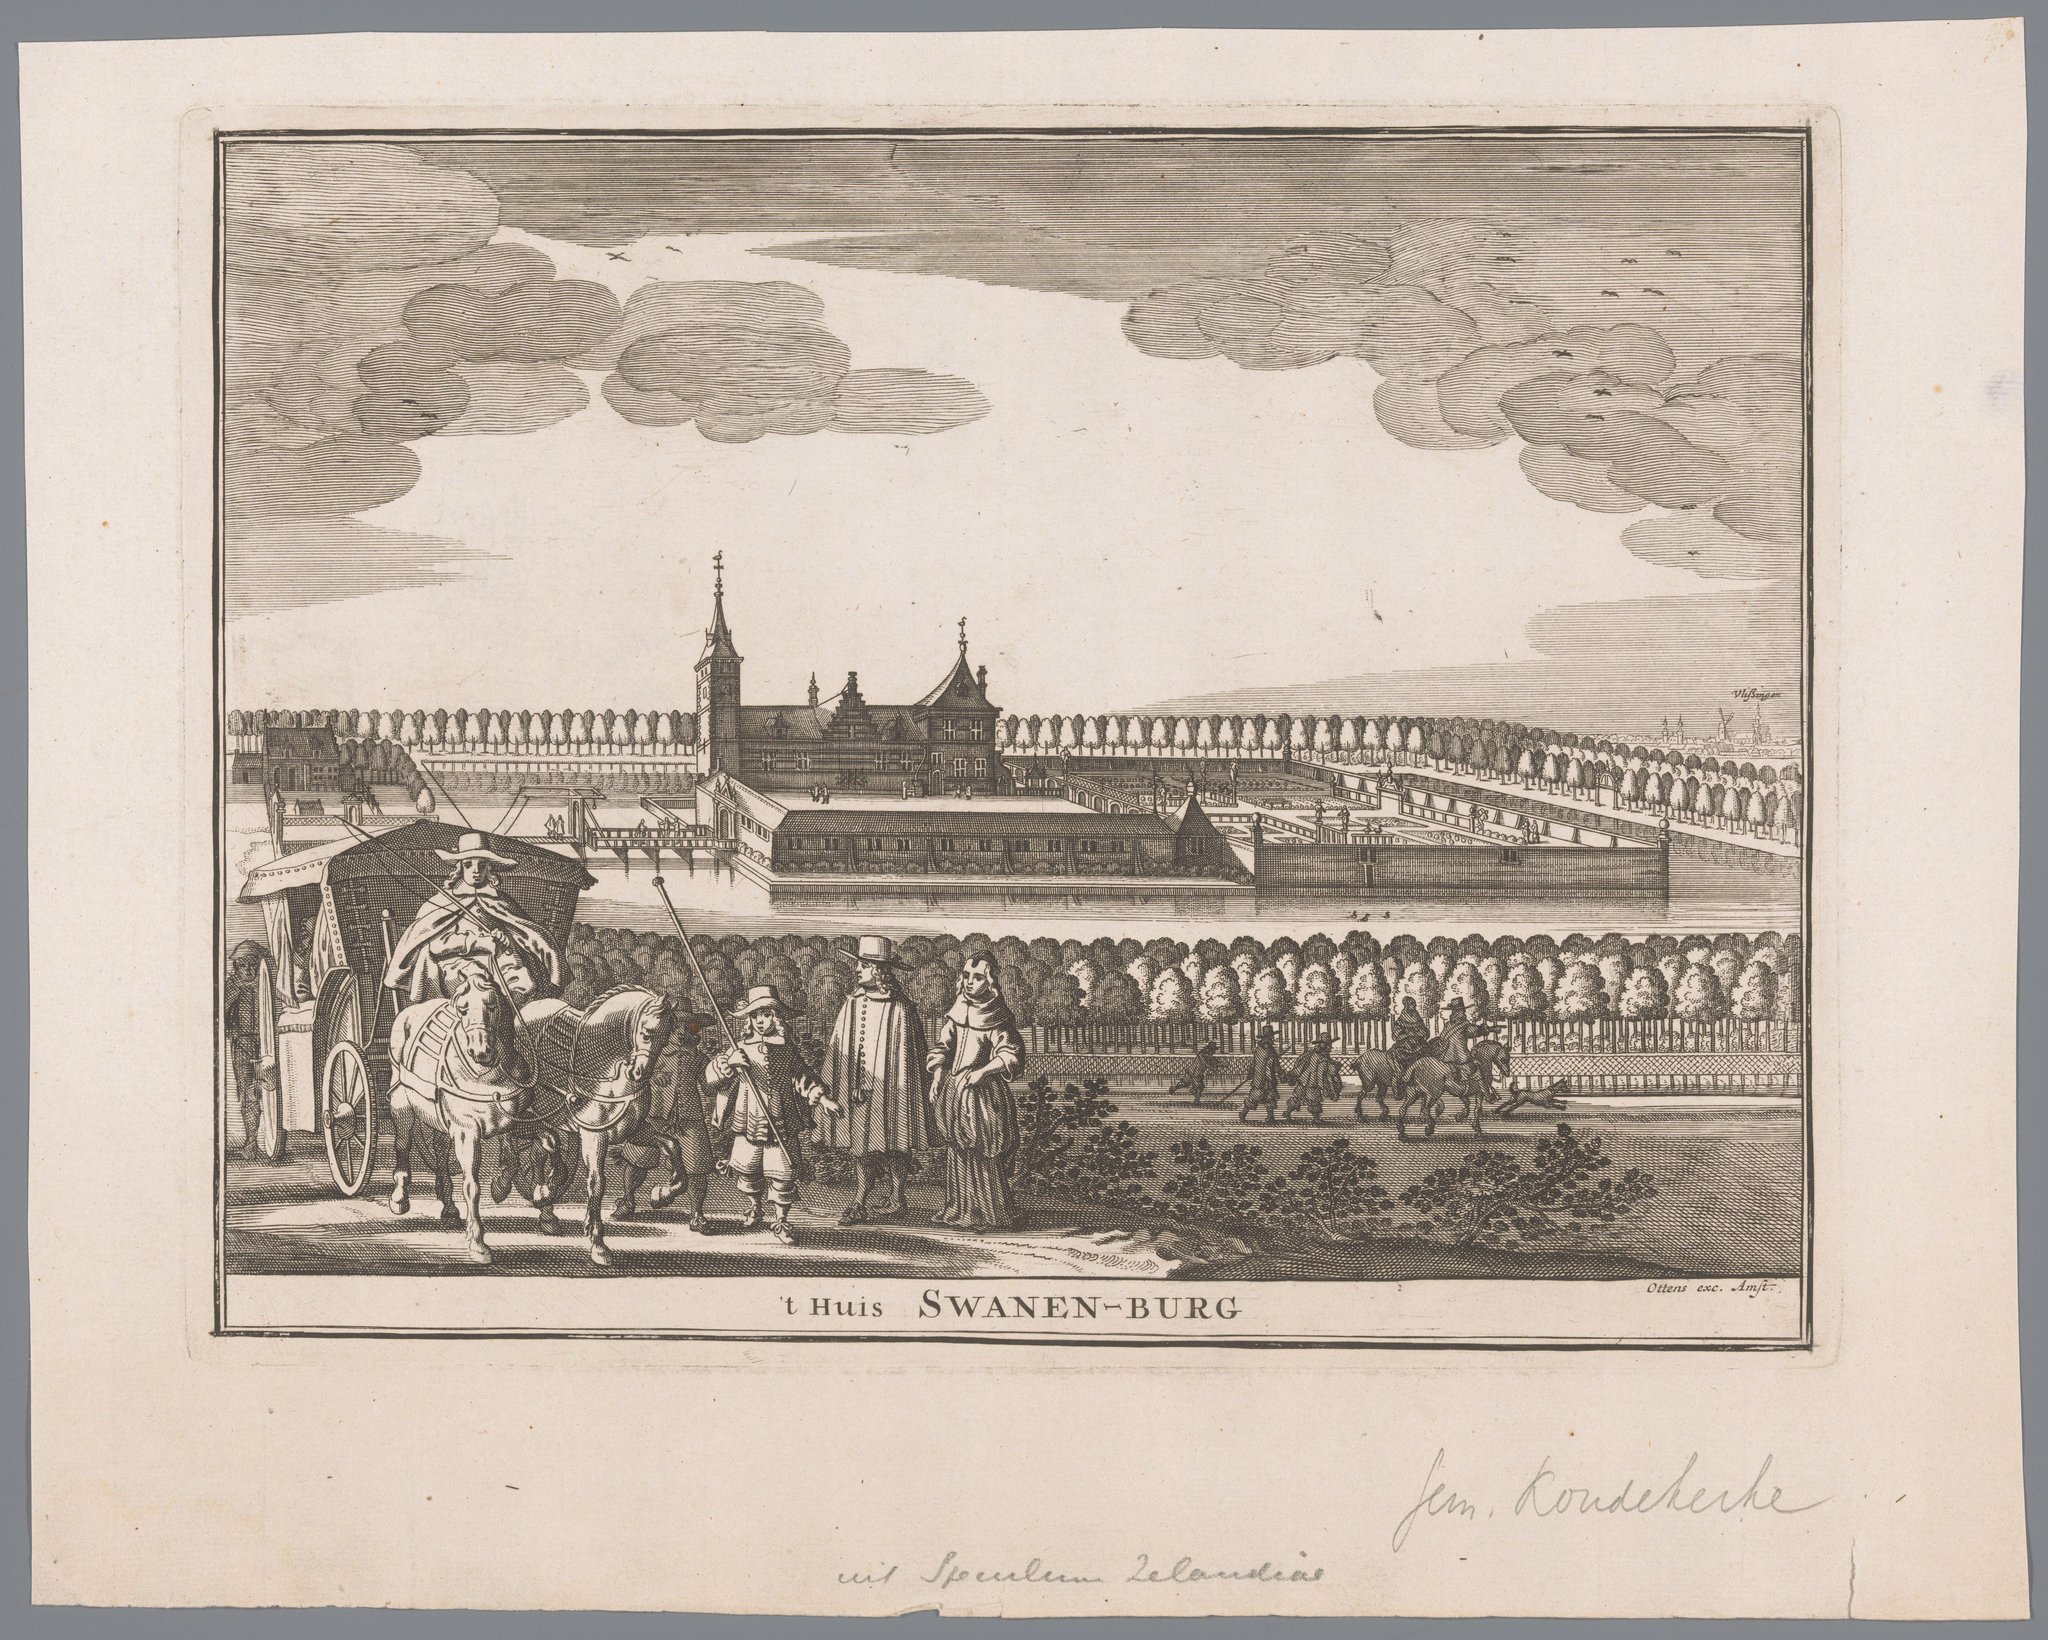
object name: print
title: Gezicht op de buitenplaats Zwanenburg met Vlissingen op de achtergrond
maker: pieter hendricksz. schut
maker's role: print maker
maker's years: 1618-1660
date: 1719-1725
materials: paper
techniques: engraving, etching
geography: amsterdam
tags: prospect of village, silhouette of village, castle, four-wheeled, animal-drawn vehicle, e.g.: cab, carriage, coach, flushing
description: Prent uit: Speculum Zelandiae dat is een beschryvinge ofte afbeelding der steden, ambachts-heerlijckheden, dorpen castelen, ridderlijcke hofsteden, huysen en gebouwen gelegen inde eylanden en de graeflijckheyt van Zeelandt. Amsterdam: weduwe Ottens en Zoonen, [1719-1725]. Eerdere staat/staten van prenten is/zijn gebruikt in eerdere uitgaven van 'Speculum Zelandiae' en in andere publicaties uitgegeven door Zacharias Roman en Nicolaes Visscher (I). De eerste publicatie waarin de eerste staat van de prent rechtsonder voorkomt dateert uit 1656. De eerste publicatie waarin de eerste staat van de andere drie prenten voorkomt dateert uit 1657.